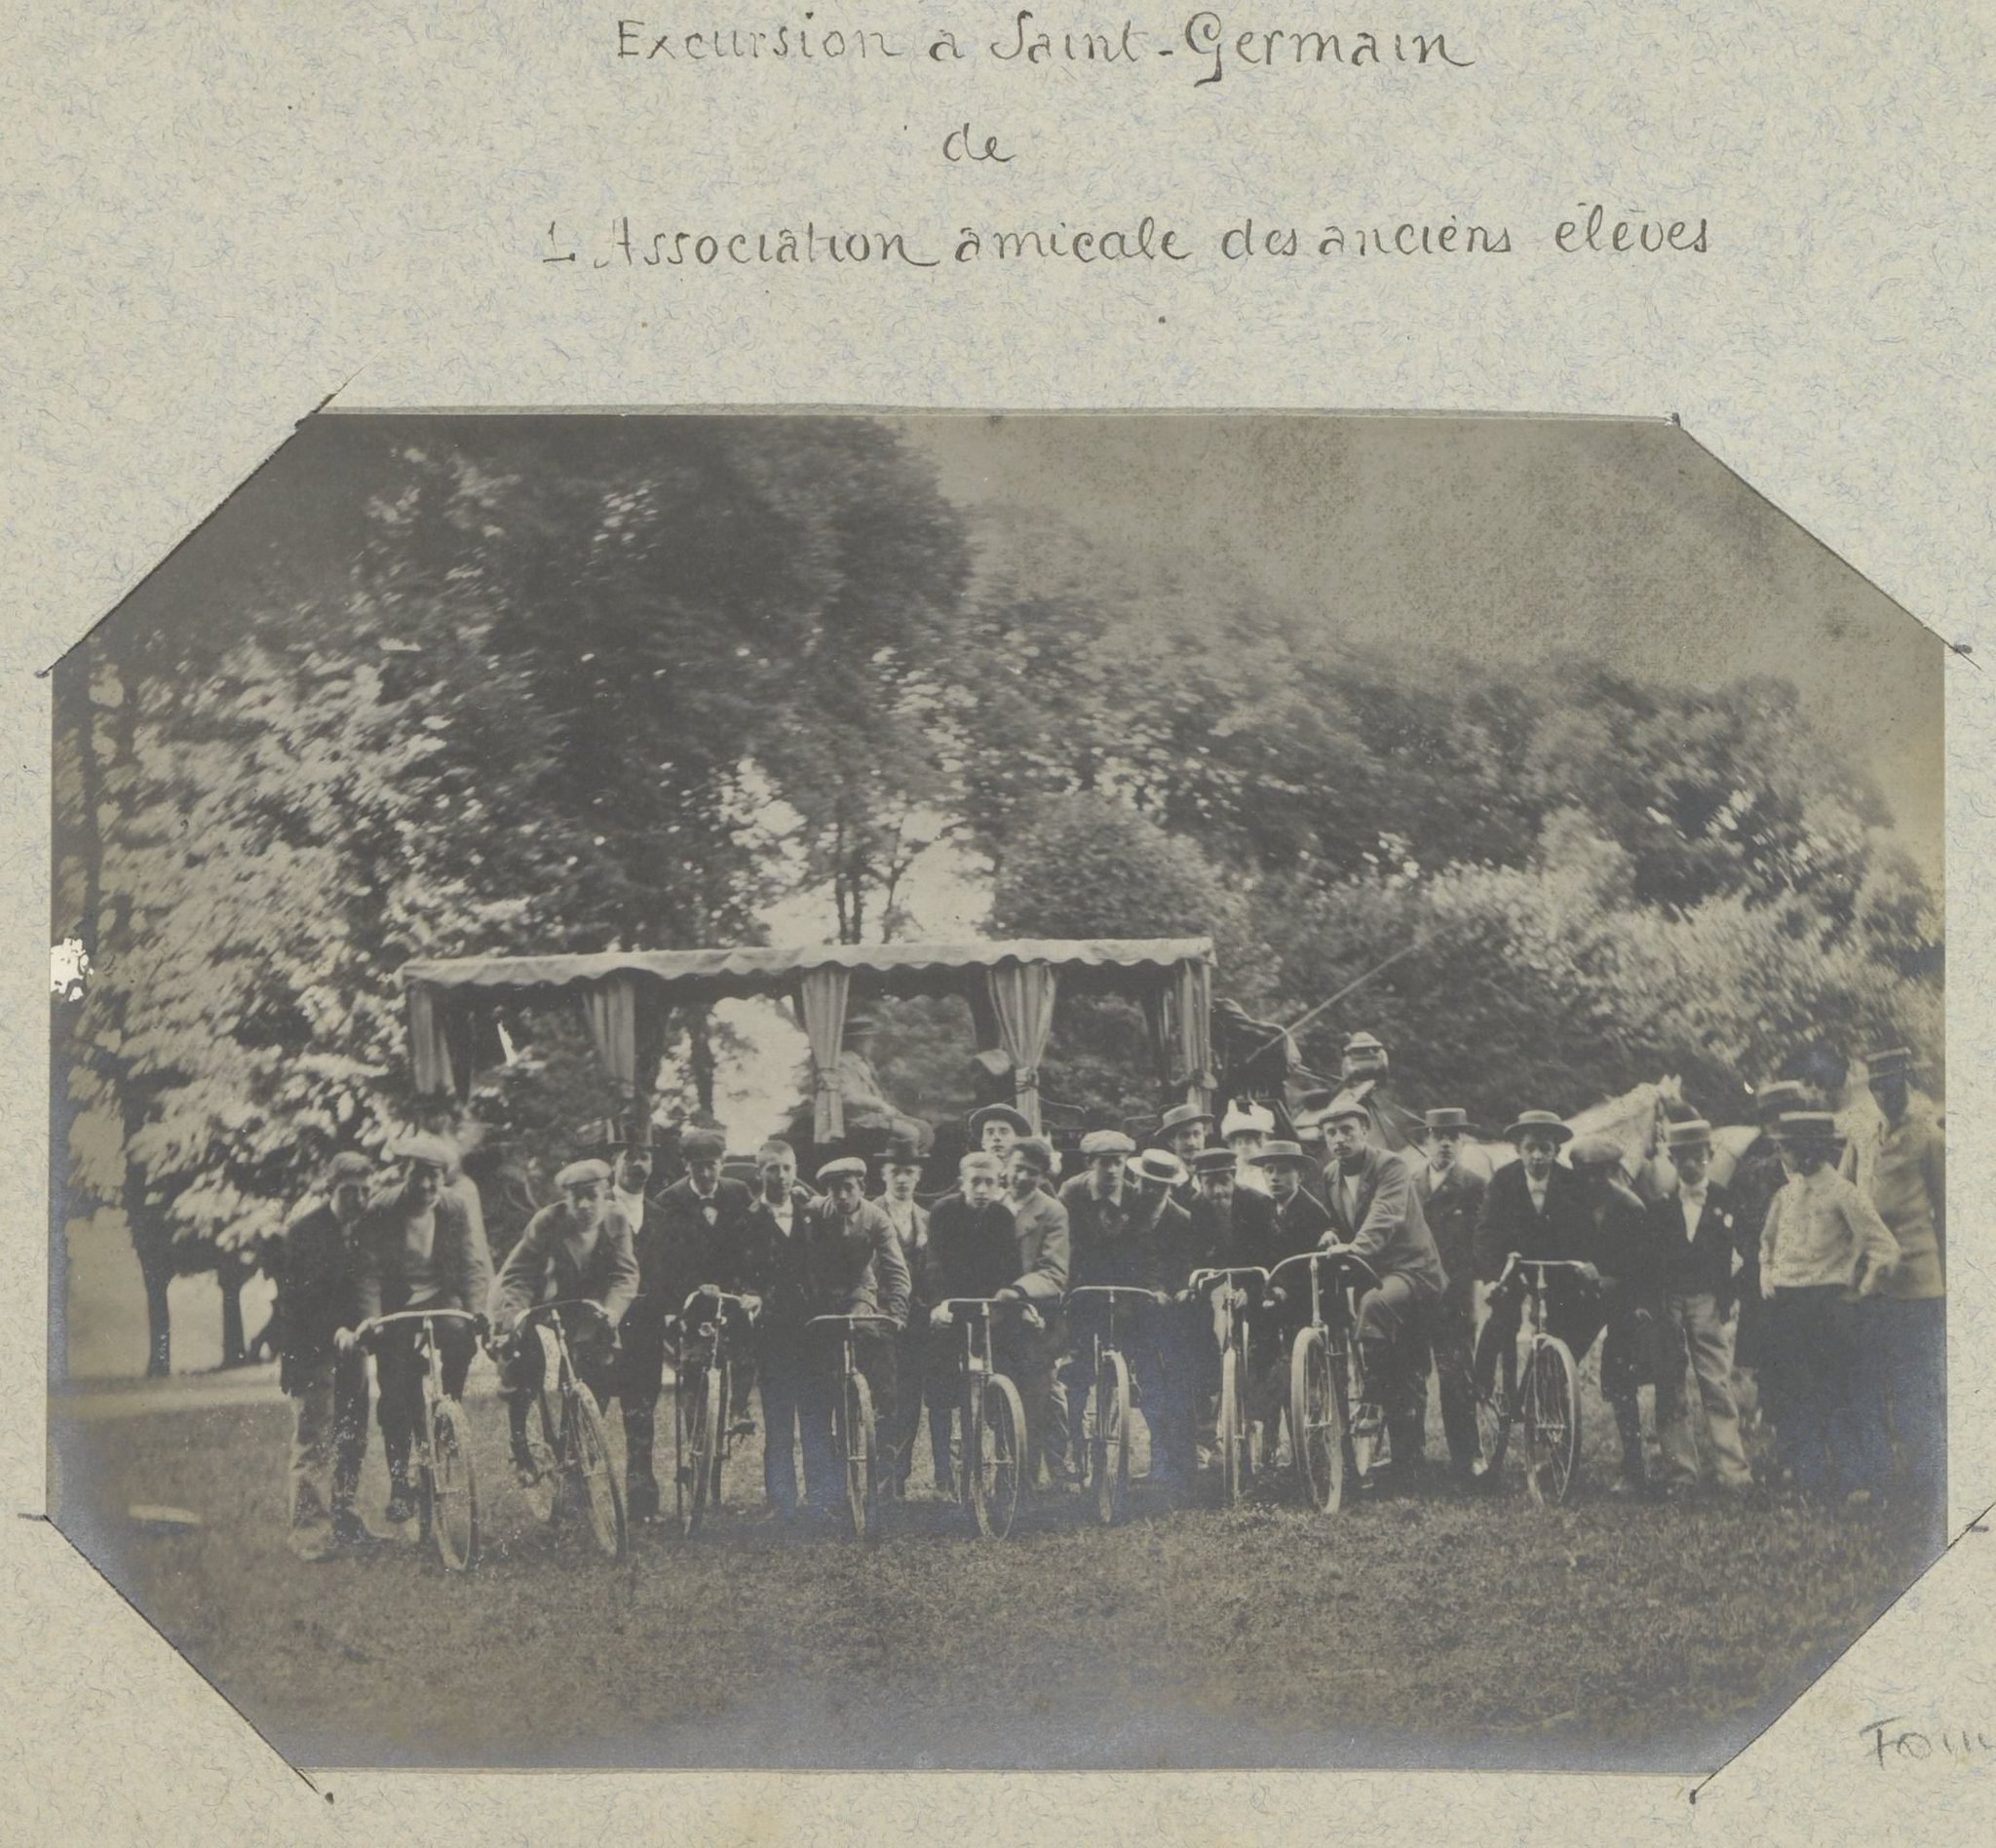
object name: album leaf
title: Groepsportret van oud-leerlingen op fietsen ('l'Association amicale des anciens élèves') tijdens een excursie naar Saint-Germain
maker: Anonymous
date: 1880-1900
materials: paper, photographic support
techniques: gelatin silver print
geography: france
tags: outing, pleasure trip, bicycle, france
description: Onderdeel van Album van een Franse amateur met foto's van Frankrijk, Algerije, Palmyra, de Wereldtentoonstelling van 1900 en van bekende Fransen.